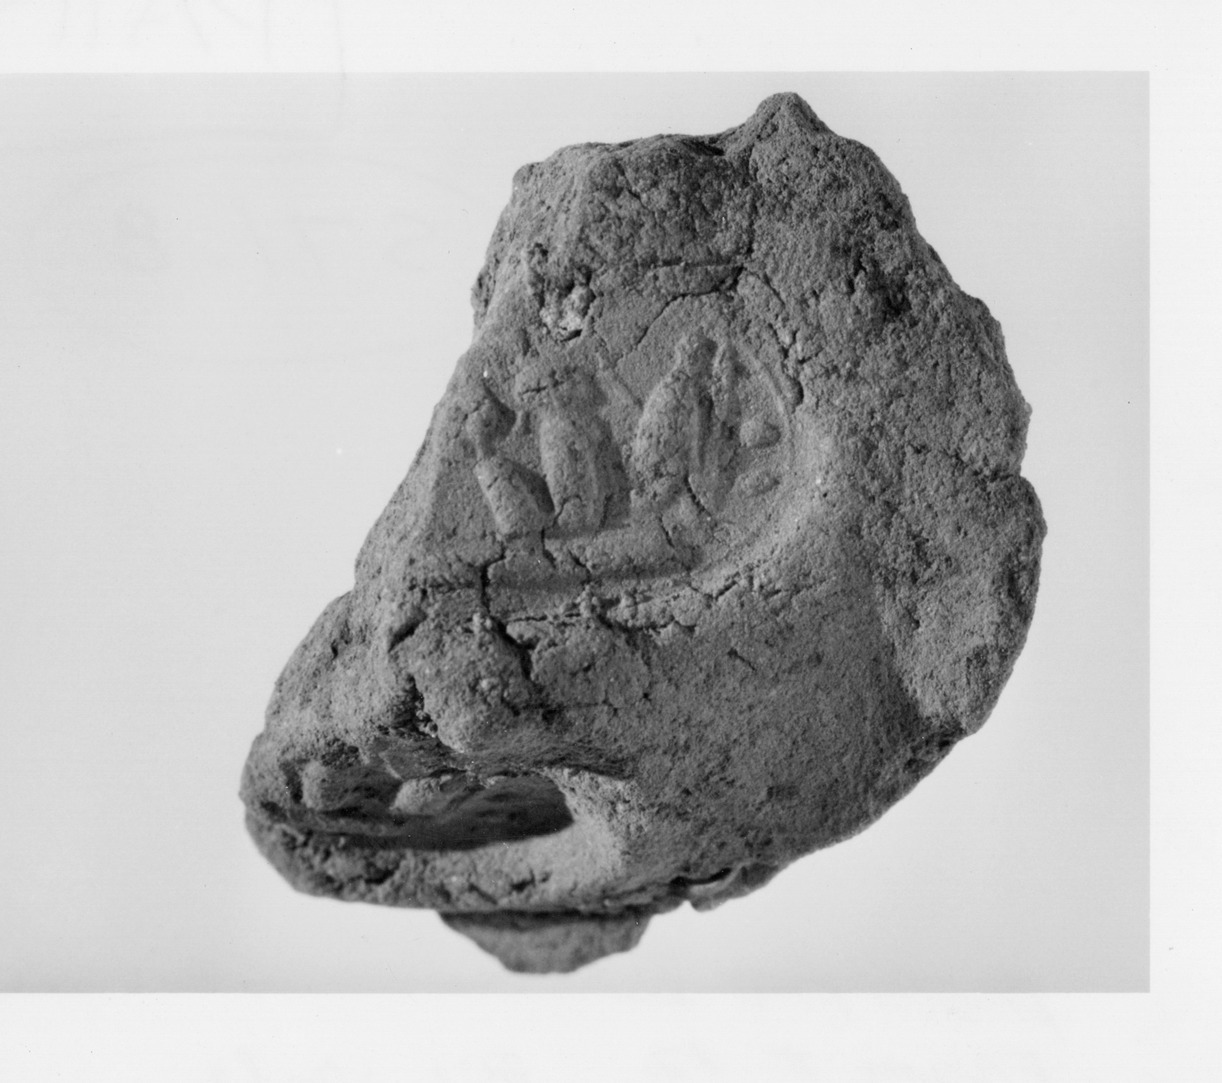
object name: sealing, nebmaatre, amenhotep iii, thoth, double crown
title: Document Sealing With the Throne Name of Amenhotep III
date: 1390-1352 BCE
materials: mud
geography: egypt